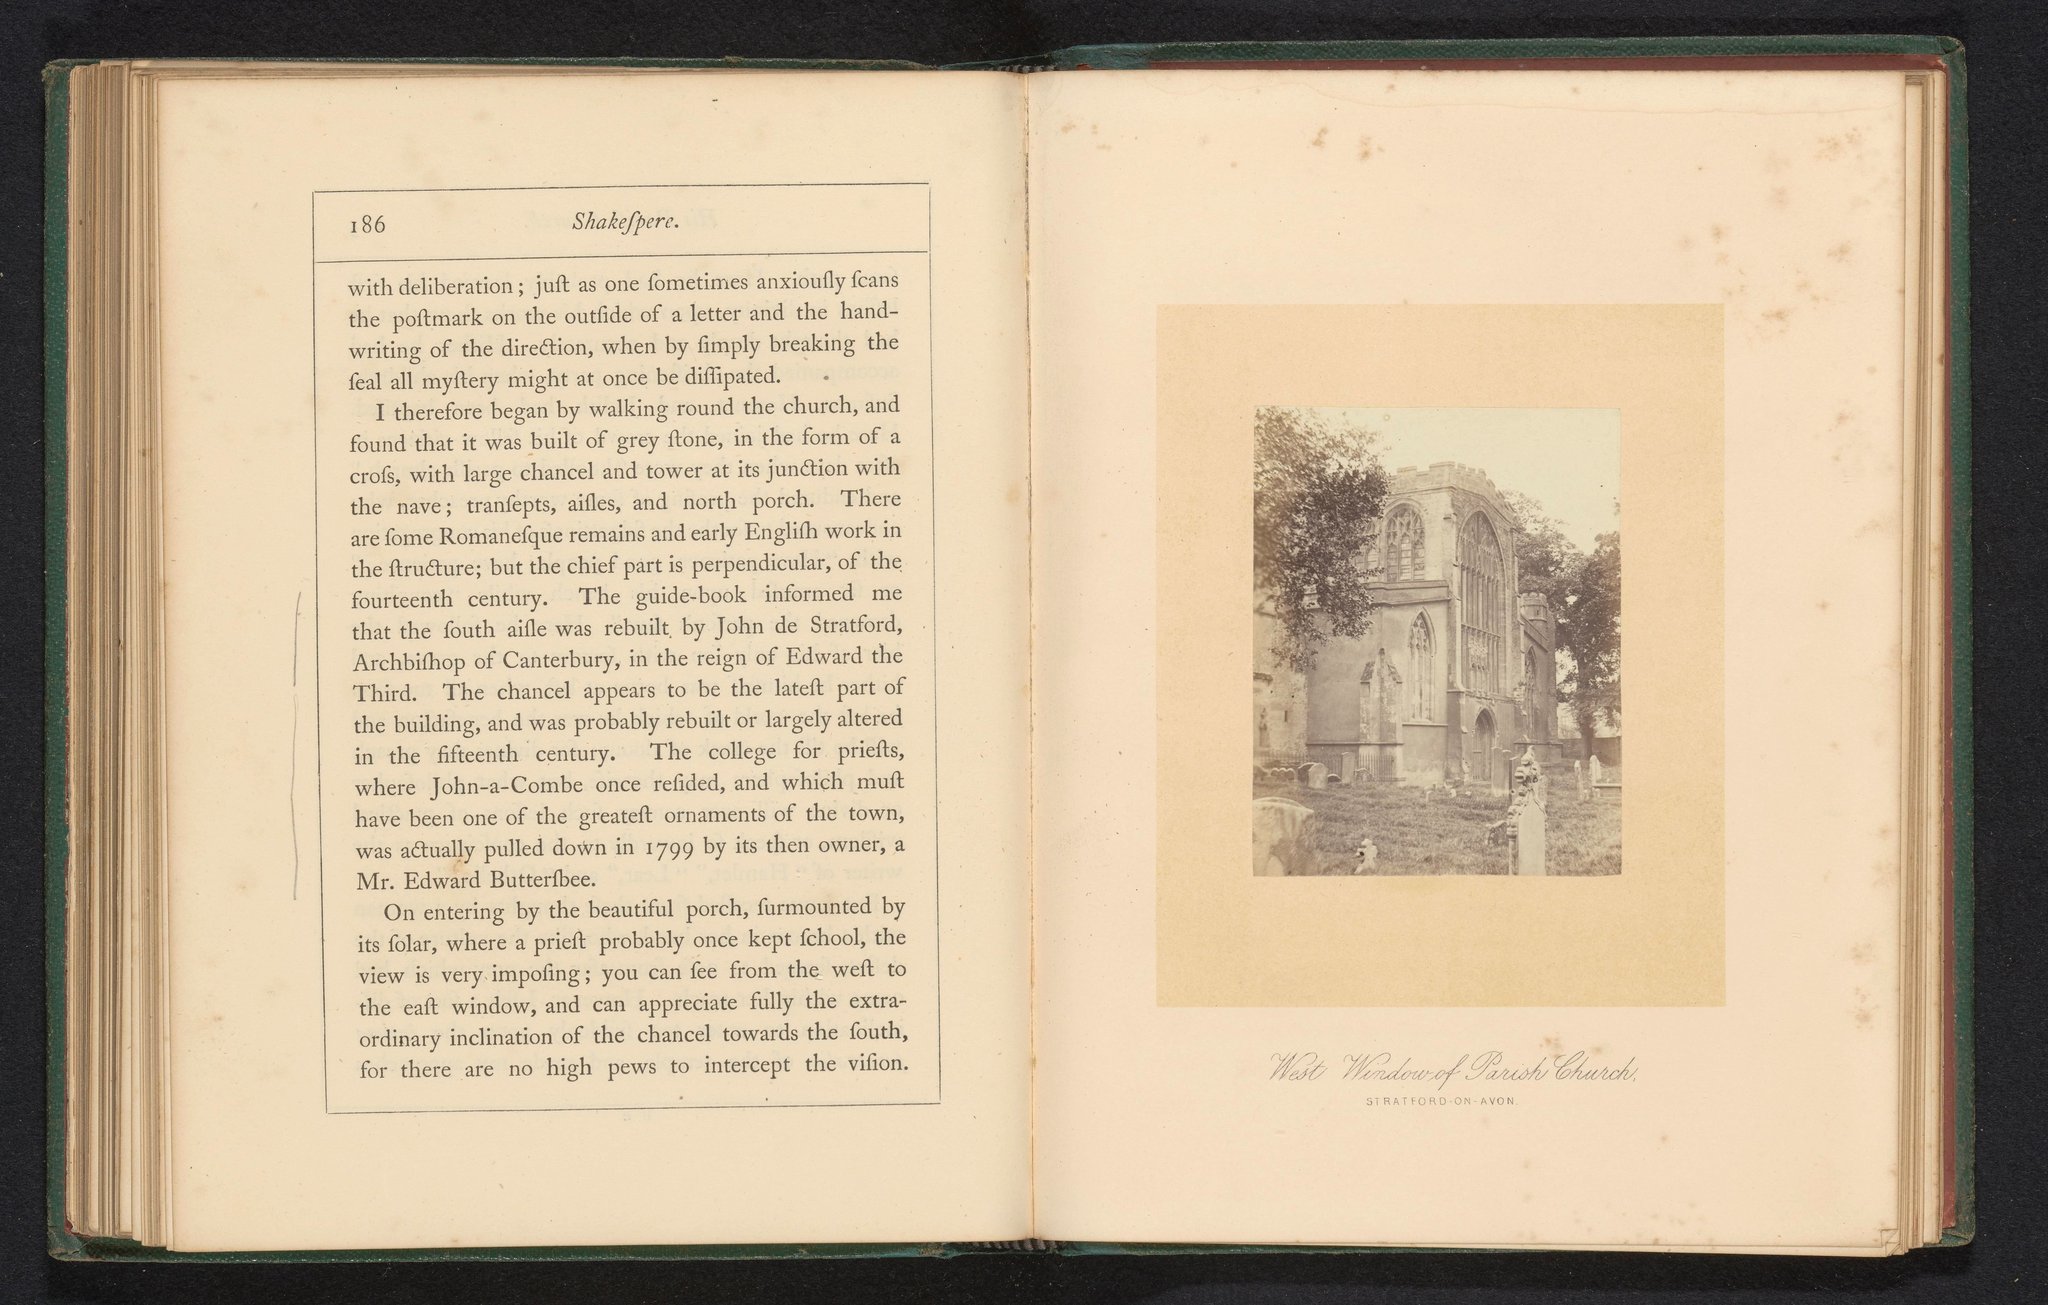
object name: page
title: West window of parish church, Stratford-on-Avon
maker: ernest edwards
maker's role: fotograaf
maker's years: 1837-1903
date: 1863-1864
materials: photographic support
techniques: albumen print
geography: stratford-upon-avon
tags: church (exterior), façade (of house or building), churchyard (around church)